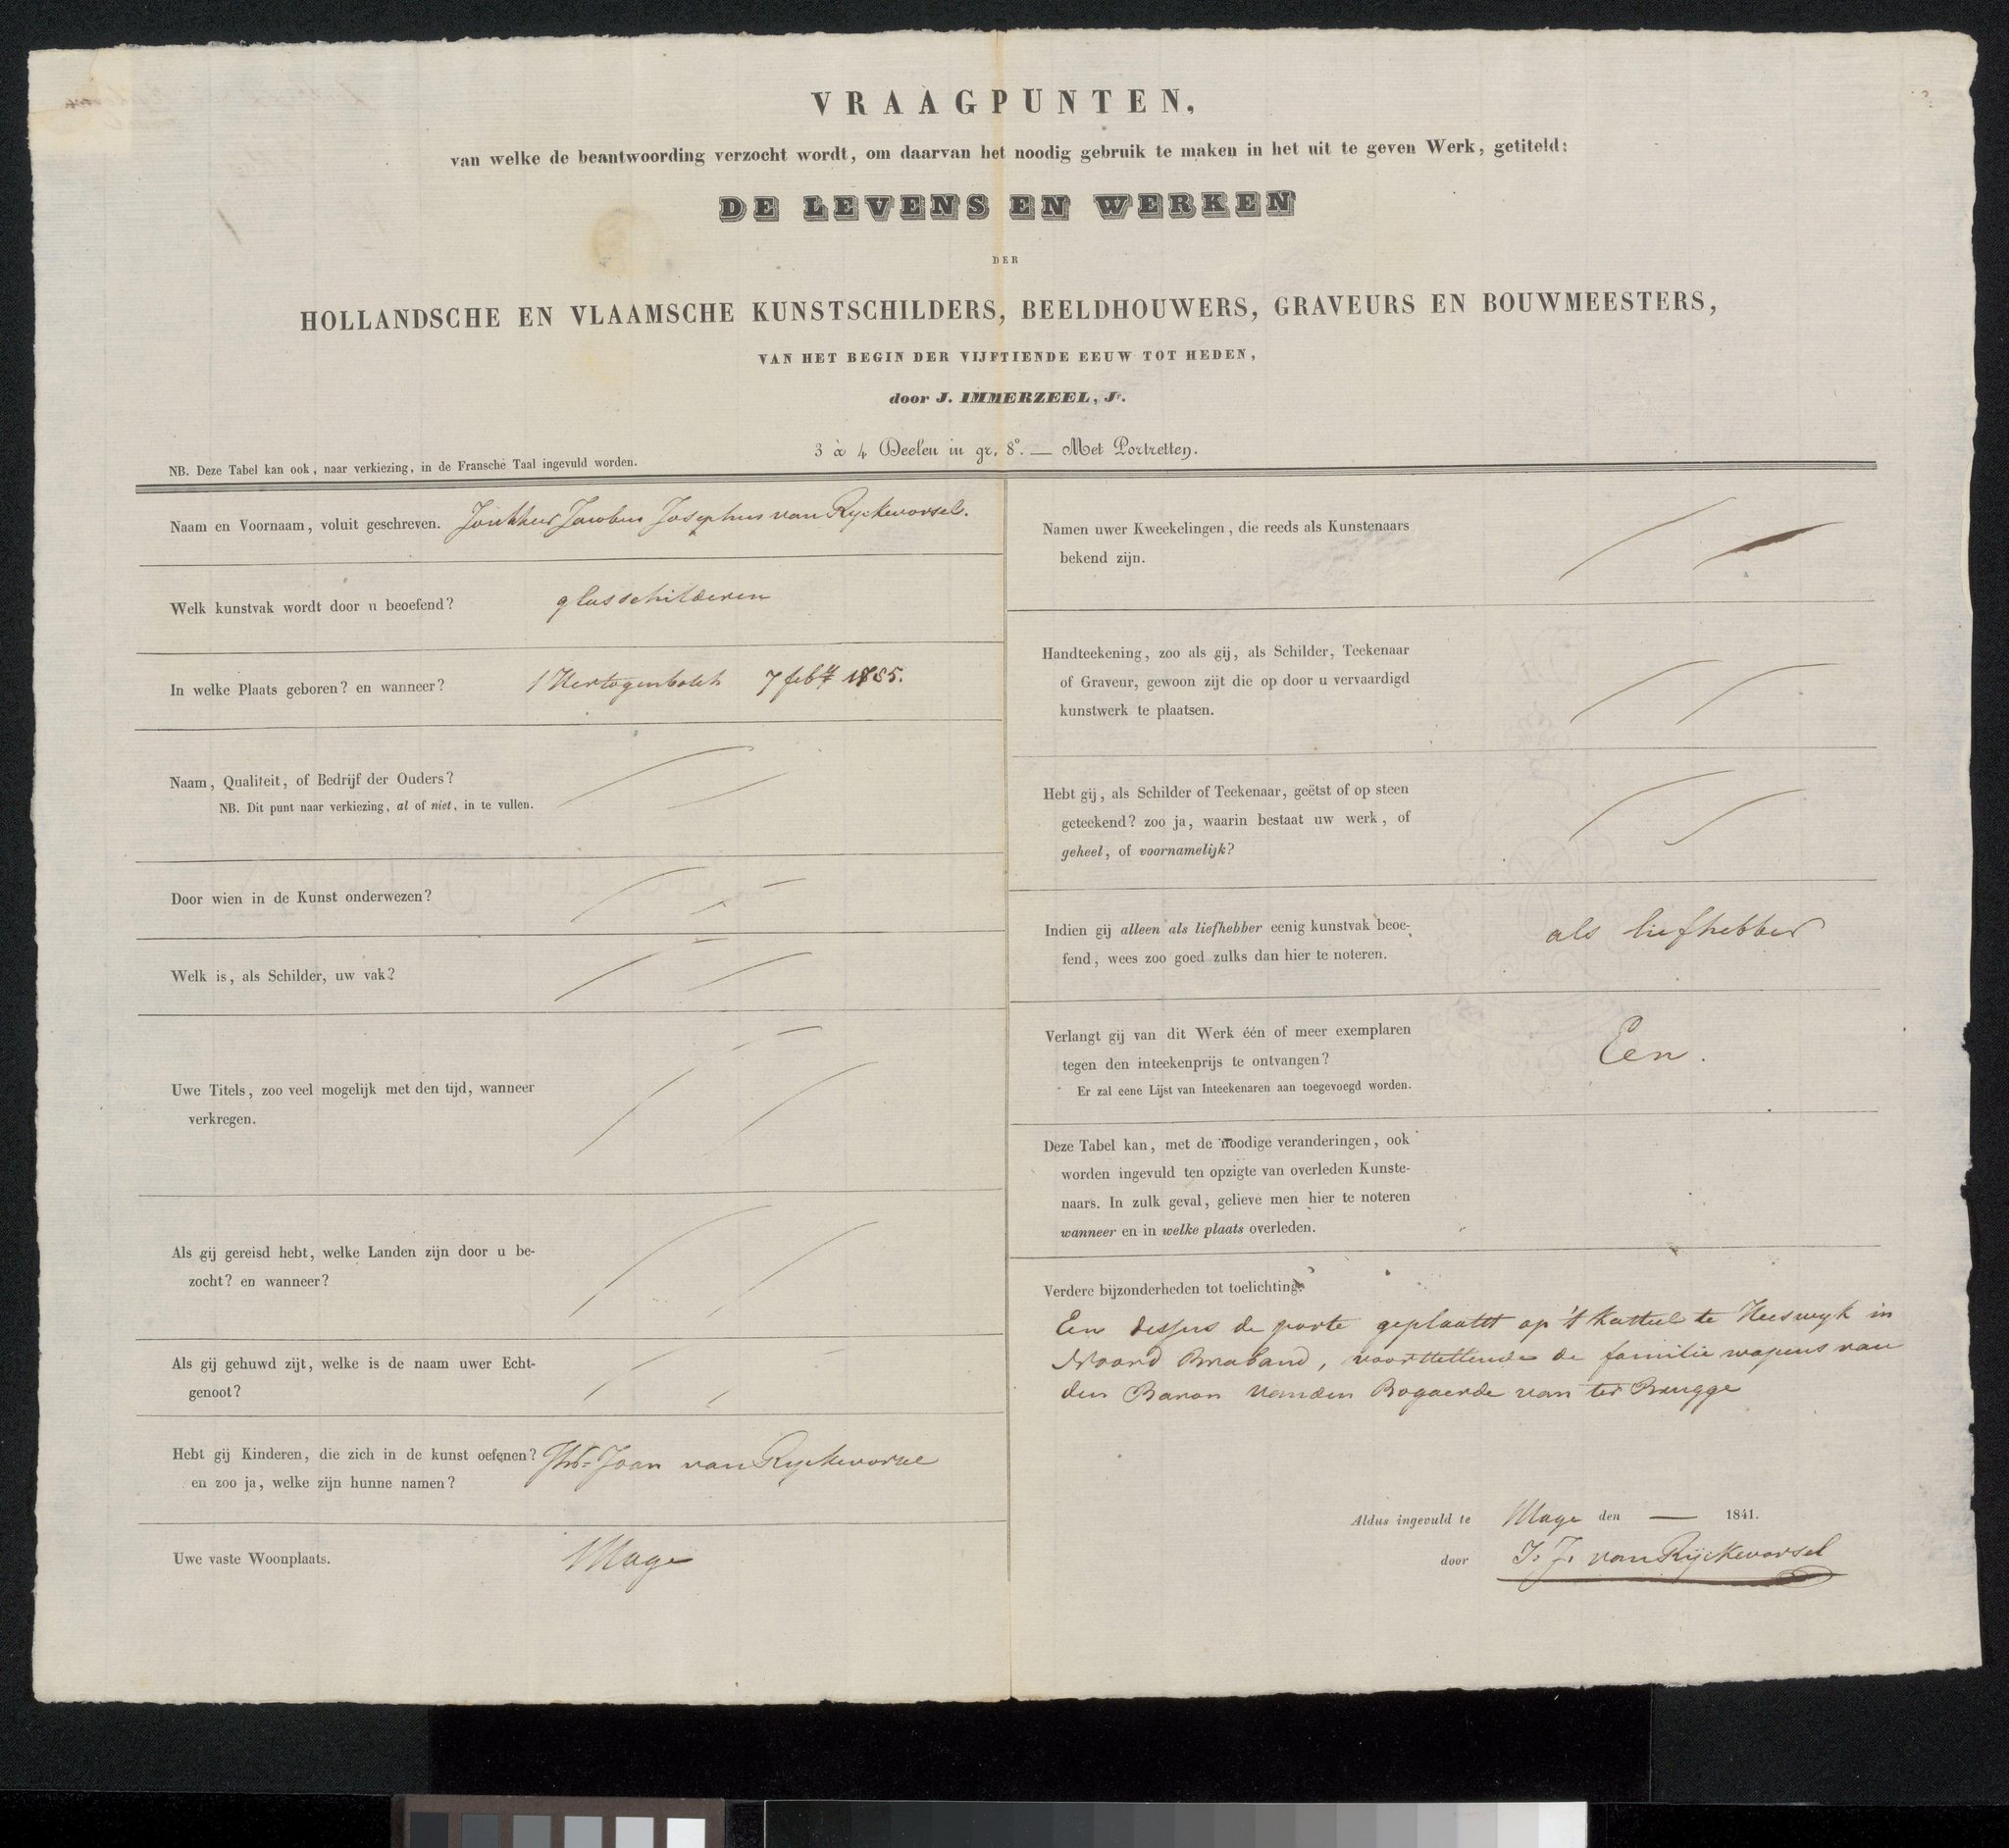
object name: questionnaire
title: Enquêteformulier ingevuld door Jacobus Josephus van Rijckevorsel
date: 1841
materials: ink, paper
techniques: pen, printing, writing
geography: the hague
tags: den bosch, painter, jacobus josephus van rijckevorsel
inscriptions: watermark, inscription: ‘Vraagpunten,/ van welke de beantwoording verzocht wordt, om daarvan het noodig gebruik te maken in het uit te geven Werk, getiteld: De levens en werken/ der Hollandsche en Vlaamsche kunstschilders, beeldhouwers,/ graveurs en bouwmeesters, van het begin der vijftiende eeuw tot heden/ door J. Immerzeel, Jr.’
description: Opgenomen in: Immerzeel, J. Jr., De levens en werken der Hollandsche en Vlaamsche kunstschilders, beeldhouwers, graveurs en bouwmeesters, van het begin der vijftiende eeuw tot heden, Amsterdam: J.C. van Kesteren, 1842-1843.